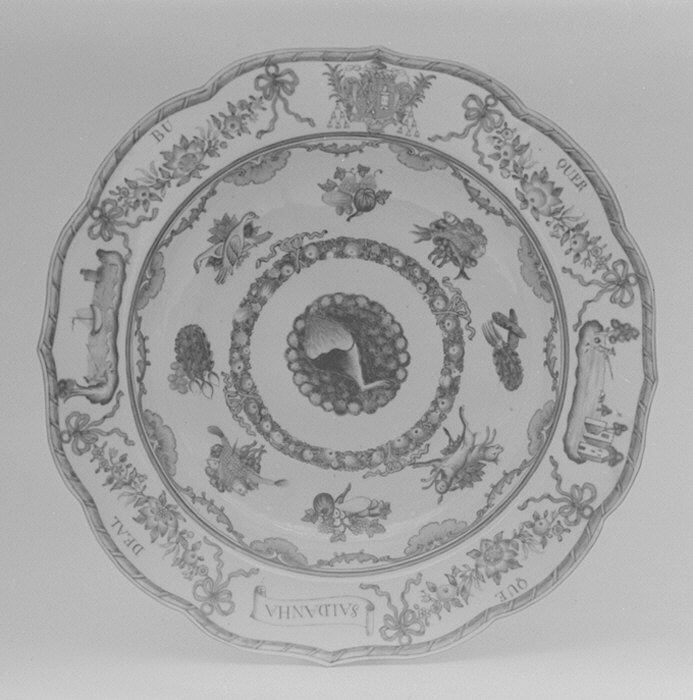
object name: soup plate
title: Soup plate (part of a service)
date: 1765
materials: hard paste porcelain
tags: birds,flowers